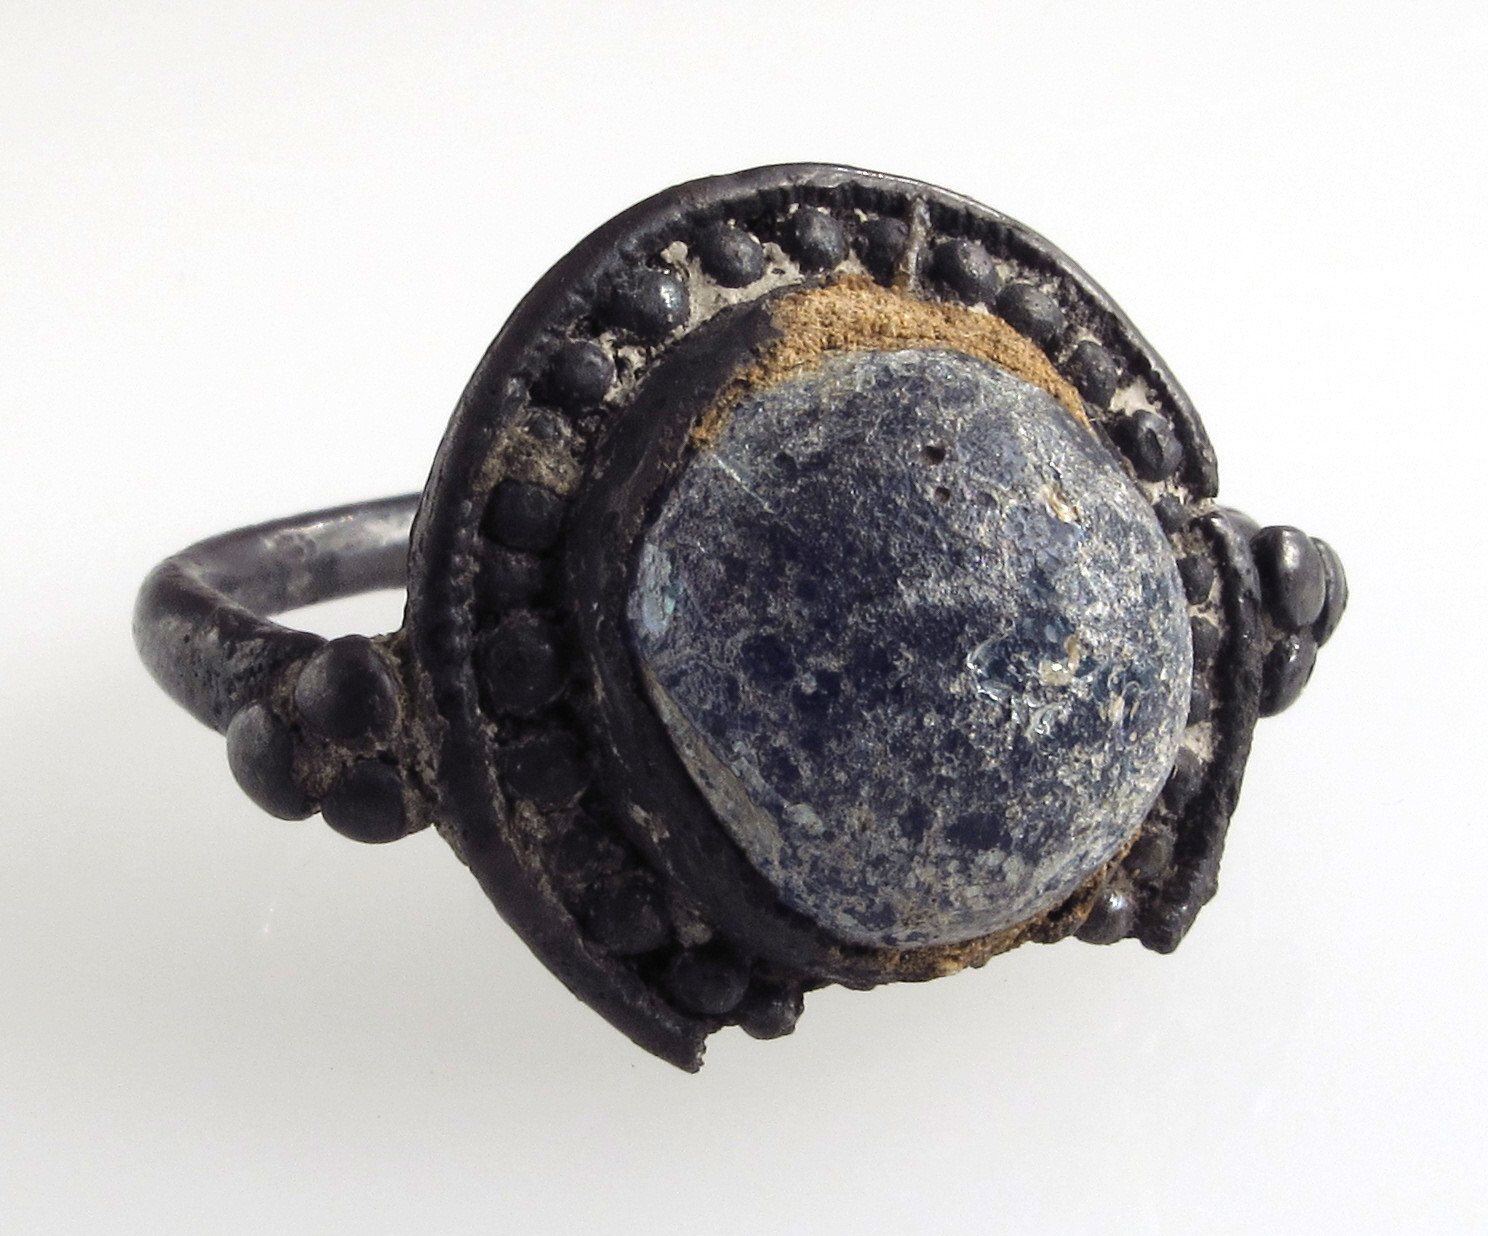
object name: ring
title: Finger Ring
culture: frankish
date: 601-700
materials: glass, silver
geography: northern france